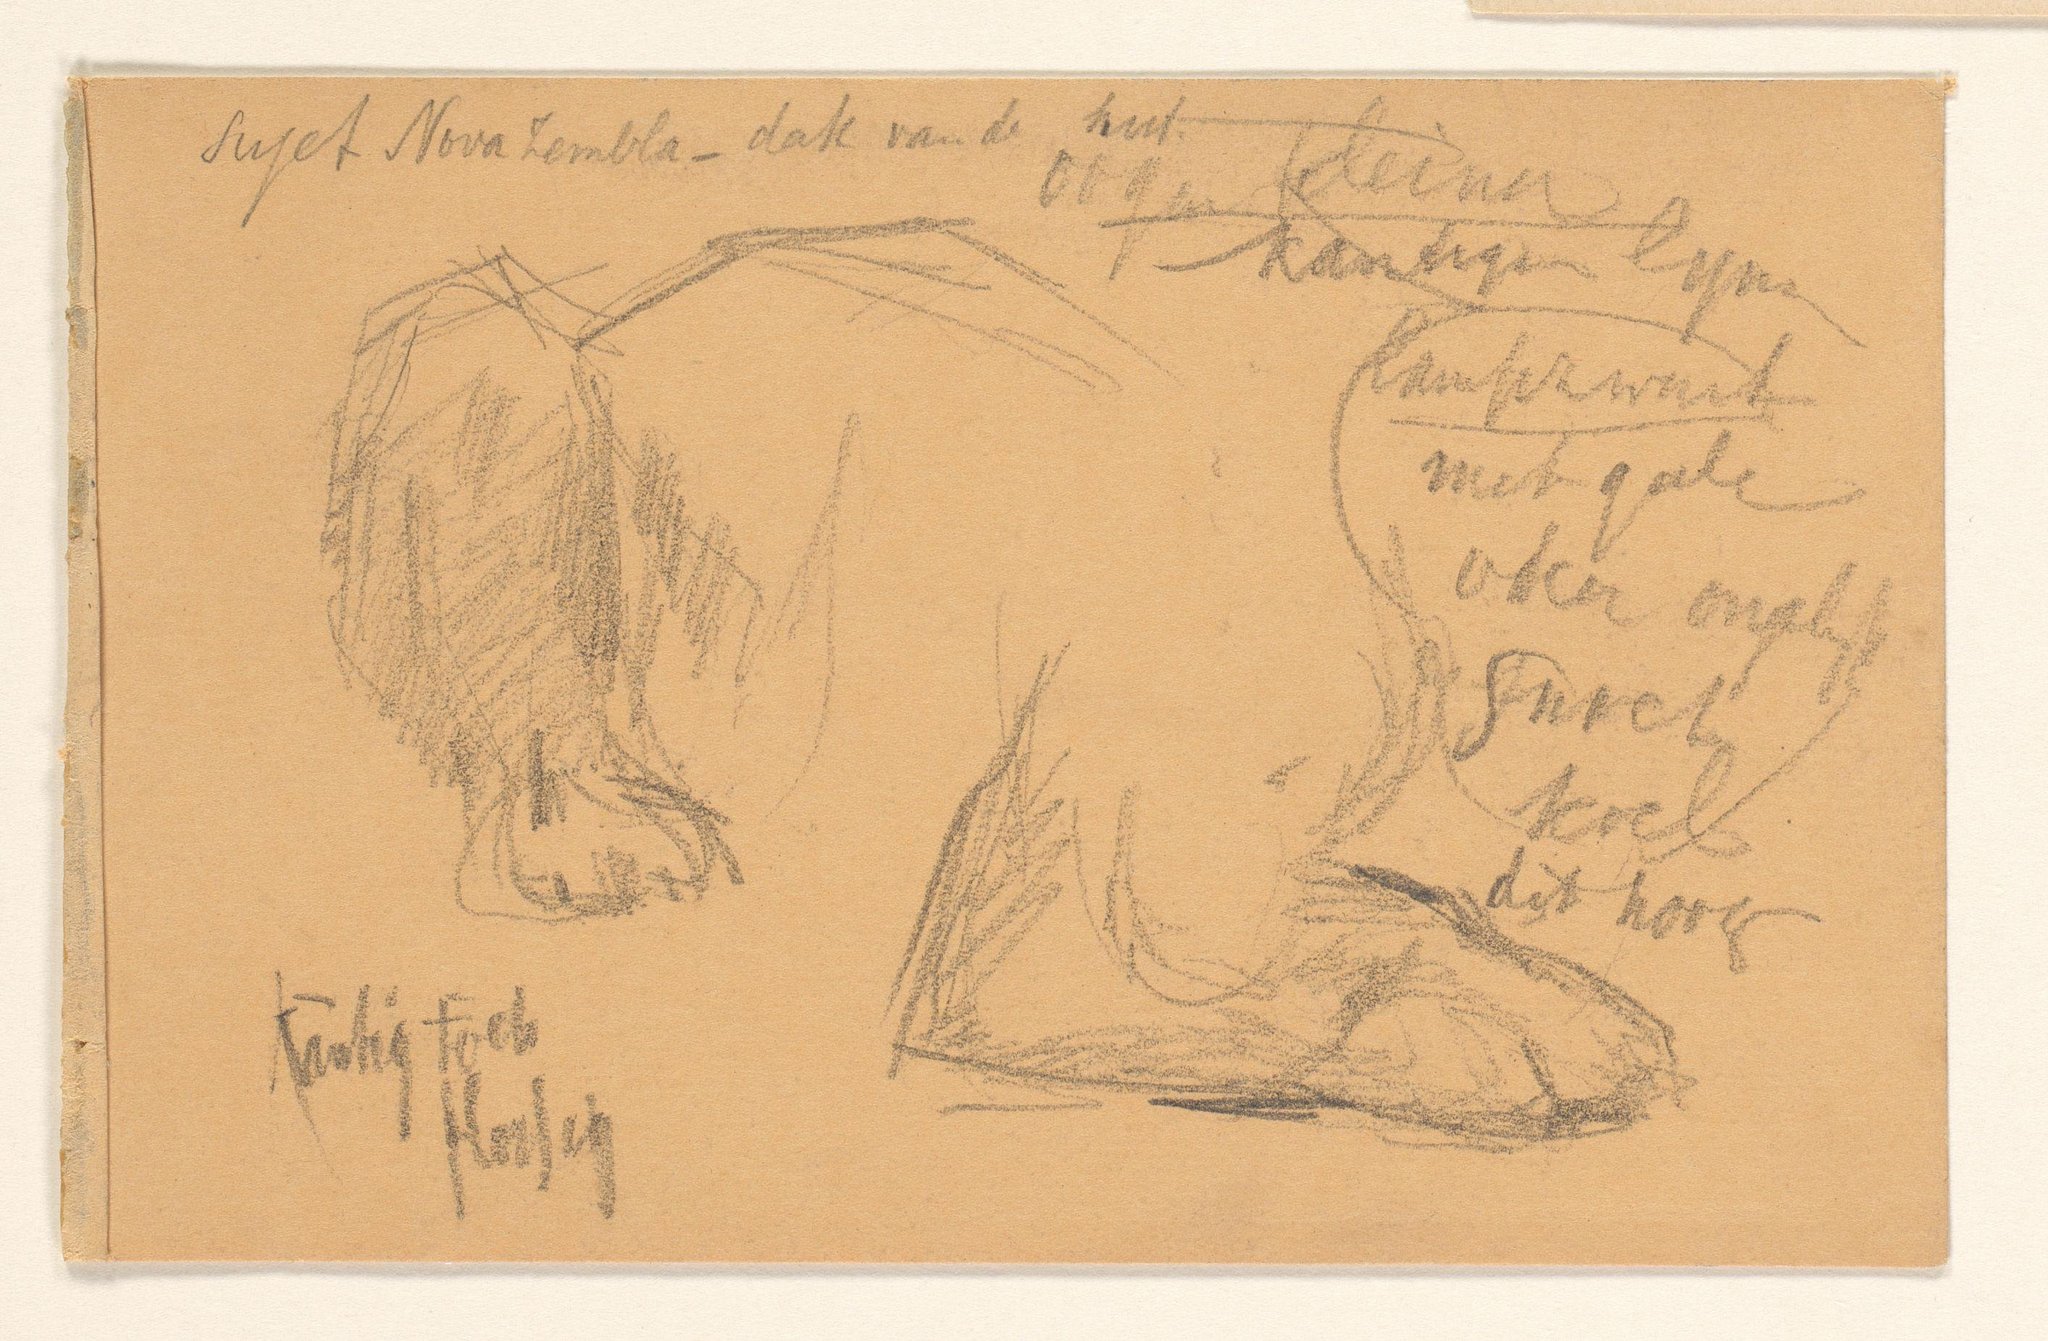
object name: drawing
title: Schetsblad met twee studies van een ijsbeerpoot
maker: august allebé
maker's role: draughtsman, print maker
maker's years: 1838-1927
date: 1848-1927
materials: paper, pencil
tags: beasts of prey, predatory animals: polar bear (+ skeleton of an animal)